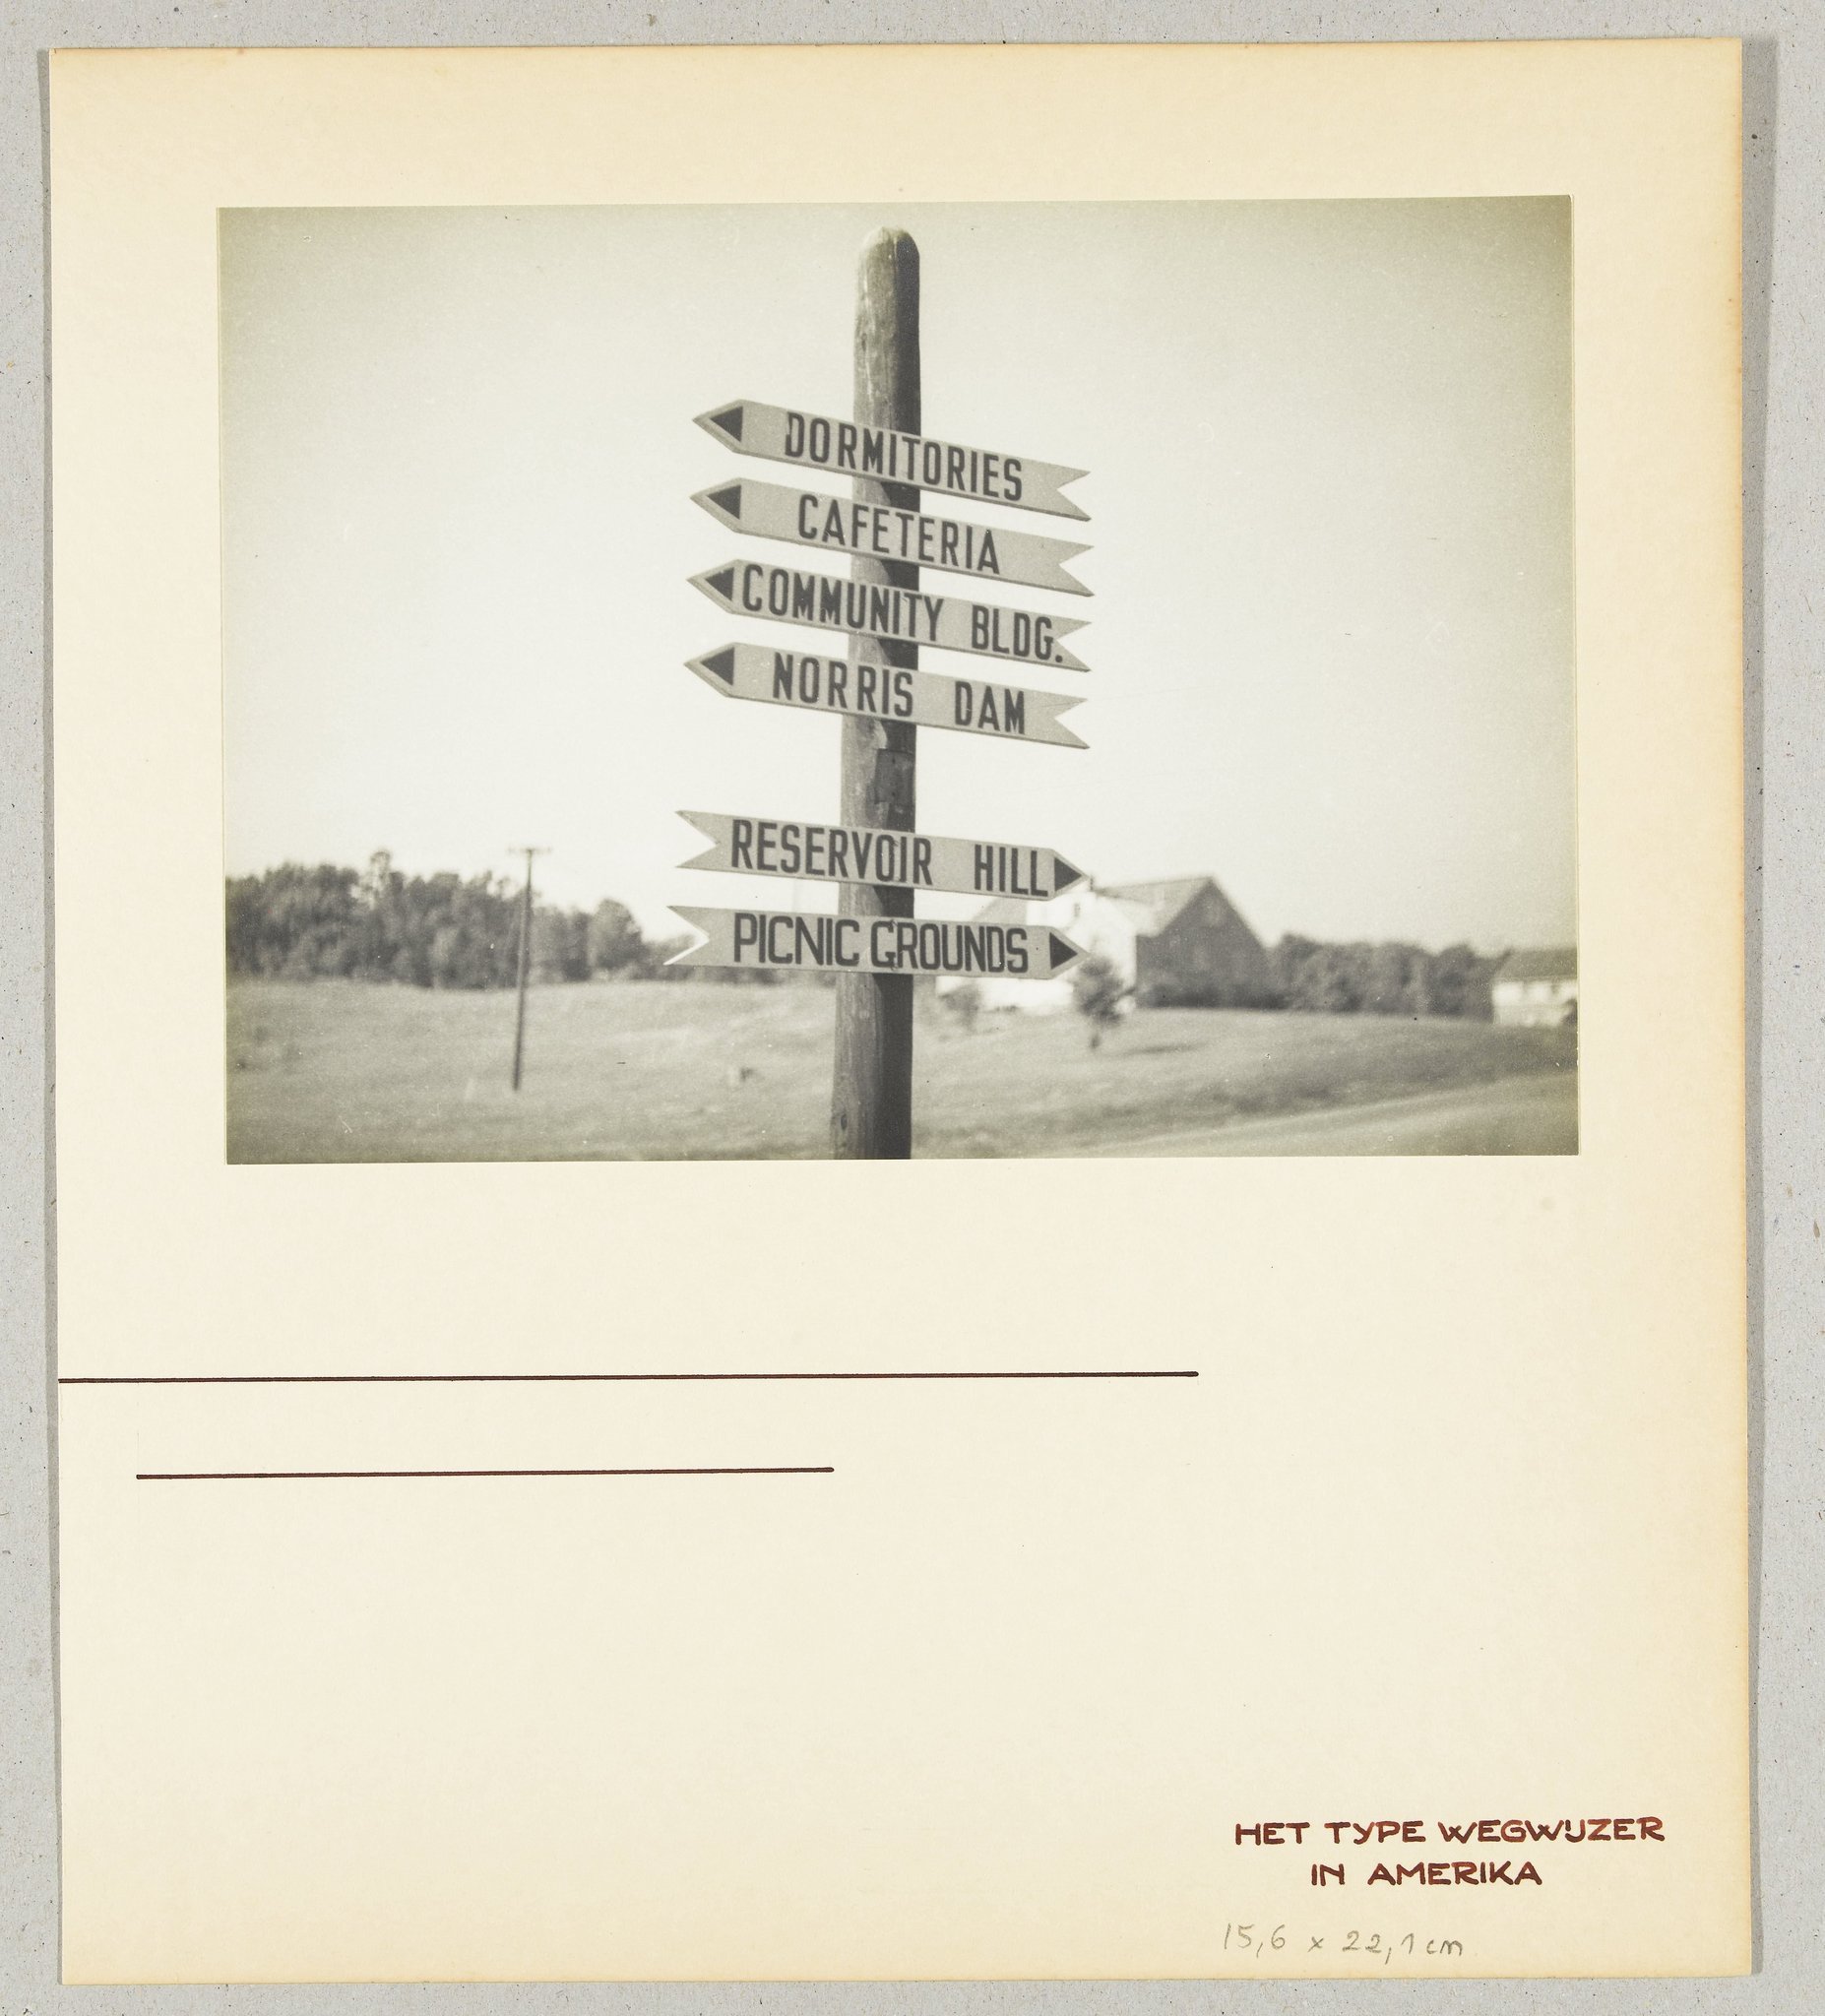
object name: photograph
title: Het type wegwijzer in Amerika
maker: wouter cool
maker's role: engineer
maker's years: 1877-1947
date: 1936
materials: cardboard, paper, photographic support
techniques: gelatin silver print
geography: united states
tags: signpost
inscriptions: title: ‘HET TYPE WEGWIJZER / IN AMERIKA’